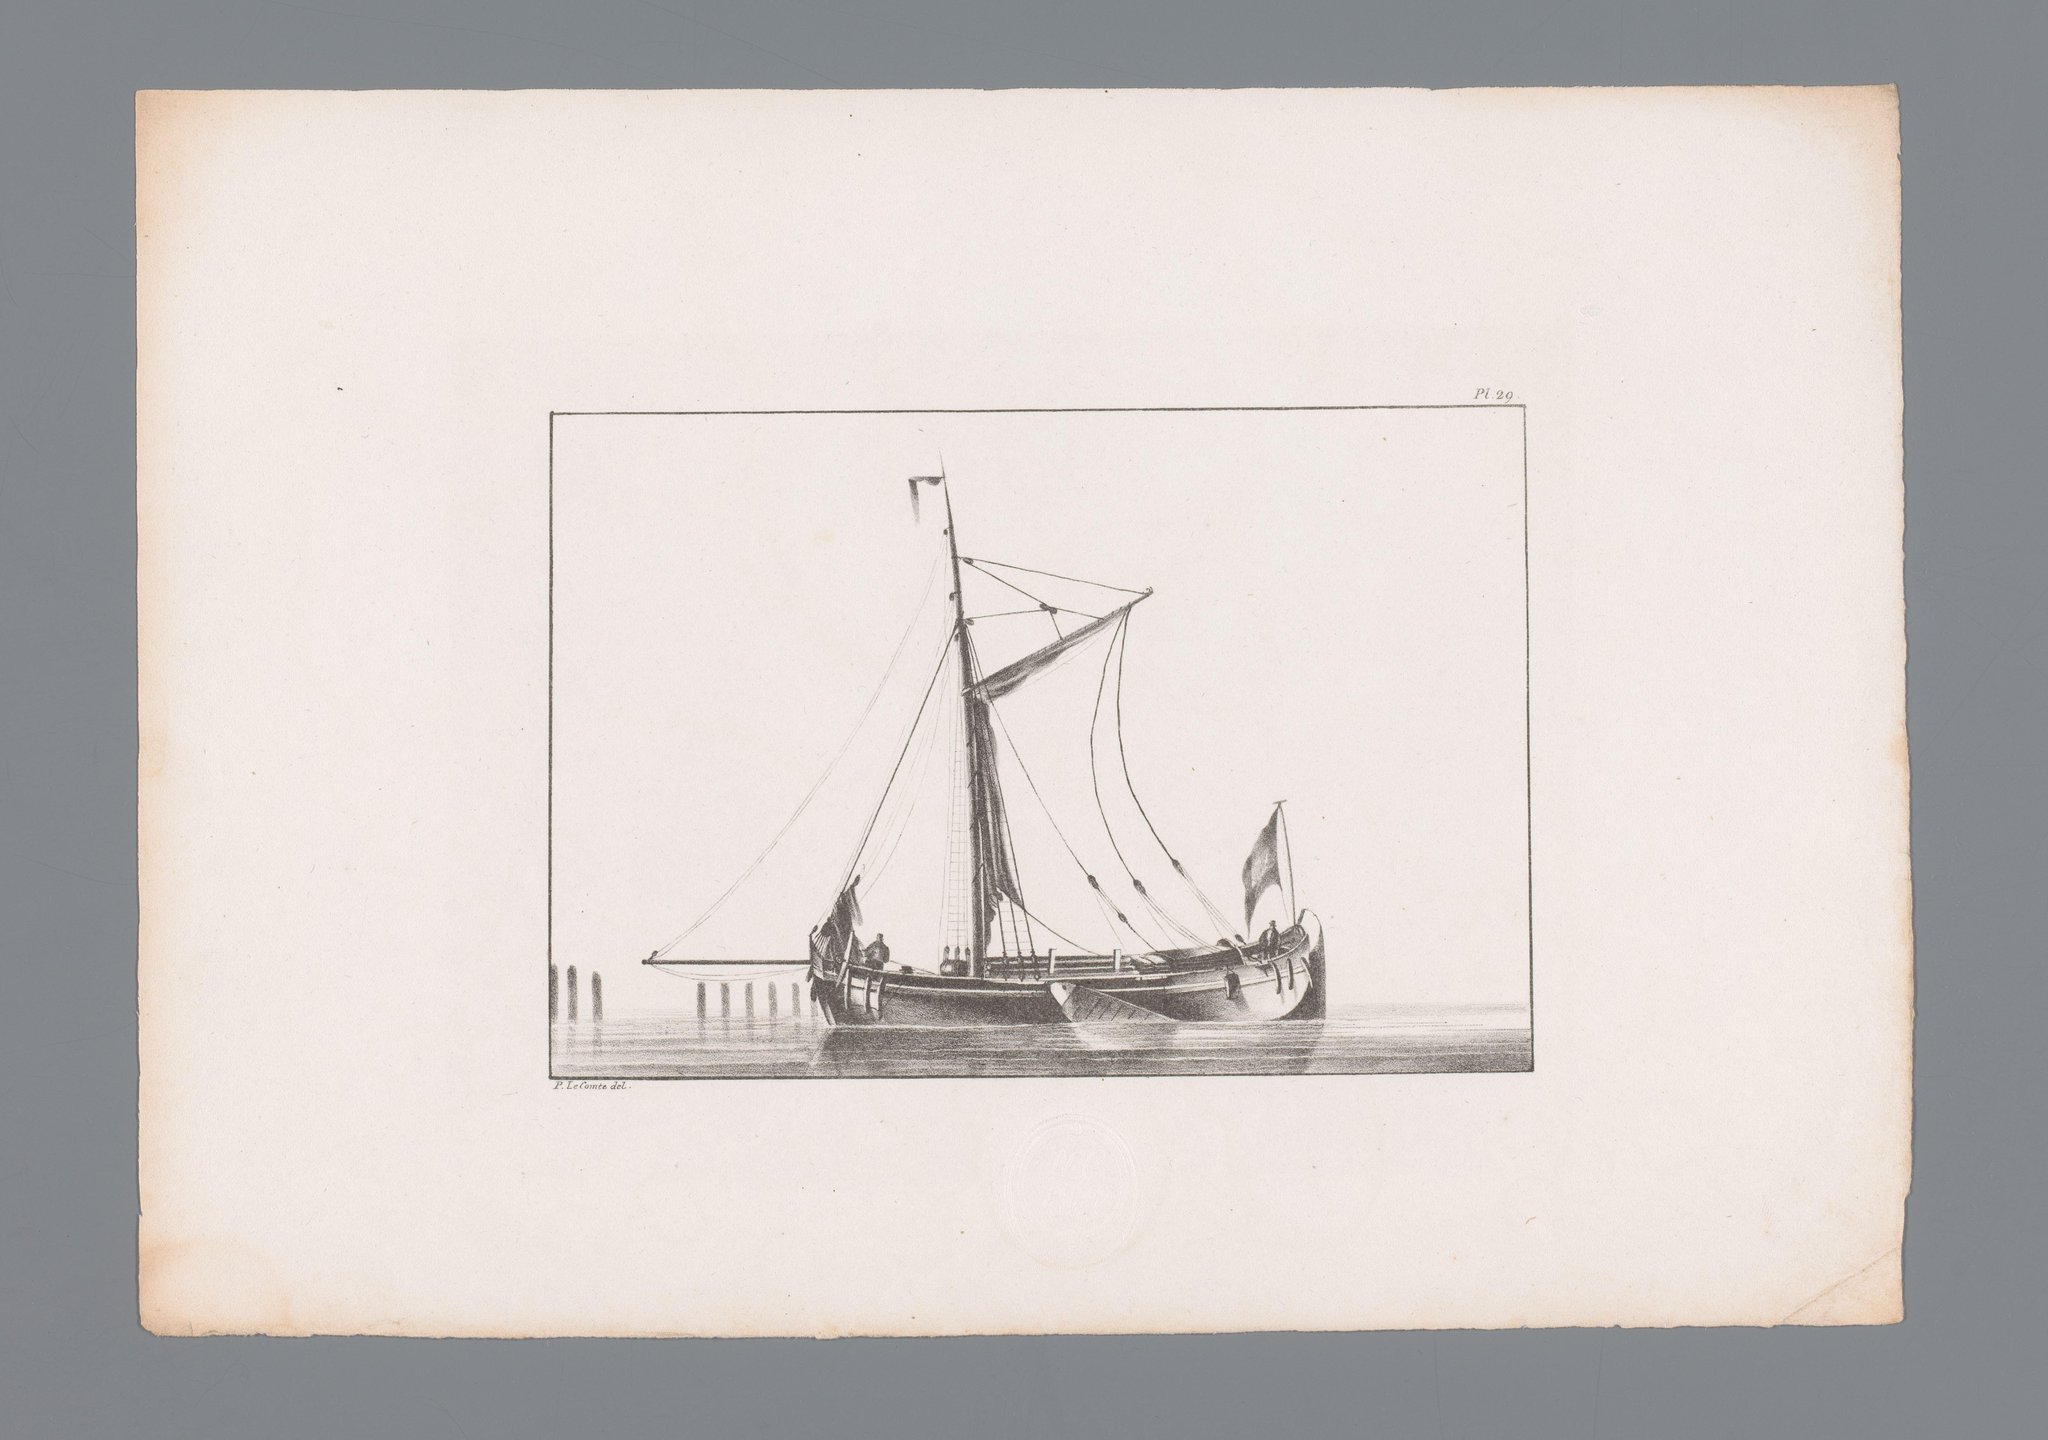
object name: print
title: Gaffelkaag, gaffelschip of lichter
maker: frederik (prins der nederlanden)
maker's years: 1797-1881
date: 1831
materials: paper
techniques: lithograph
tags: sailing-ship, sailing-boat, ships (in general)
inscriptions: collector's mark: ‘PLC RMWO’, collector's mark: Lugt 2228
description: Genummerd rechtsboven: Pl. 29. Deze prent maakt deel uit van een omslag met negentien prenten.